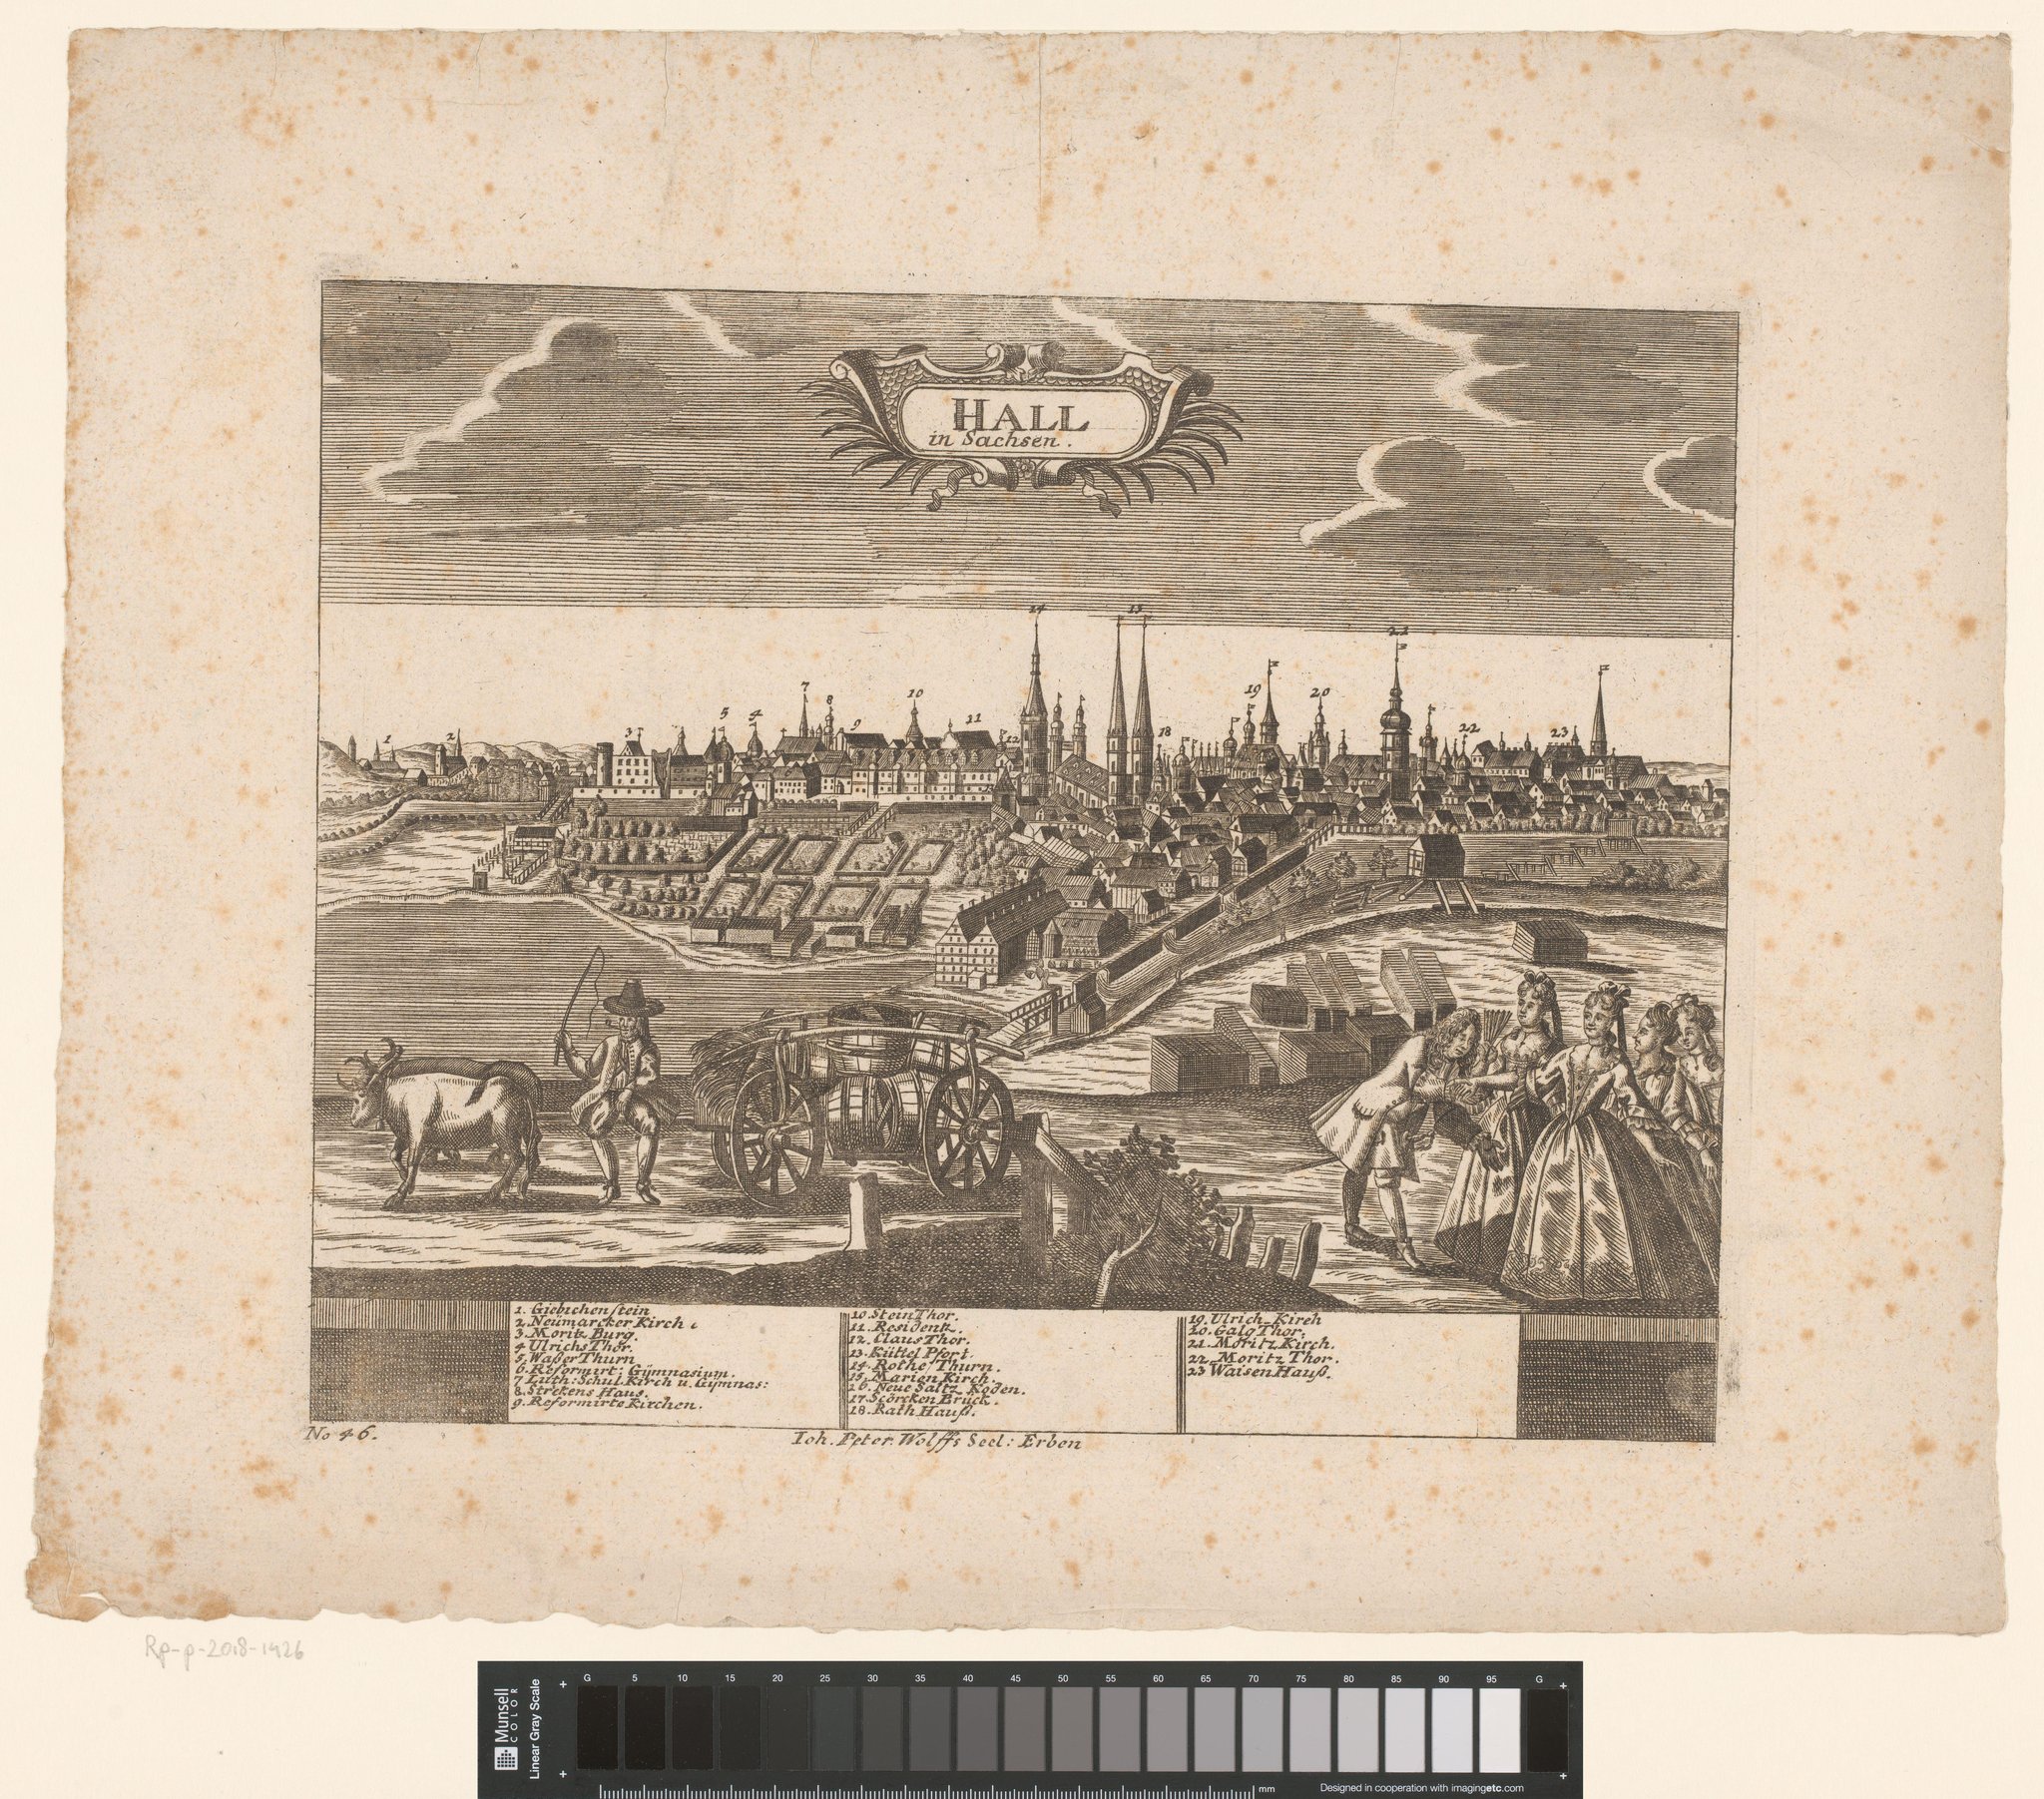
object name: print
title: Hall in Sachsen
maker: Anonymous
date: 1711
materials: paper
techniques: engraving, etching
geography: nuremberg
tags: prospect of city, town panorama, silhouette of city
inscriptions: collector's mark: Lugt 2228